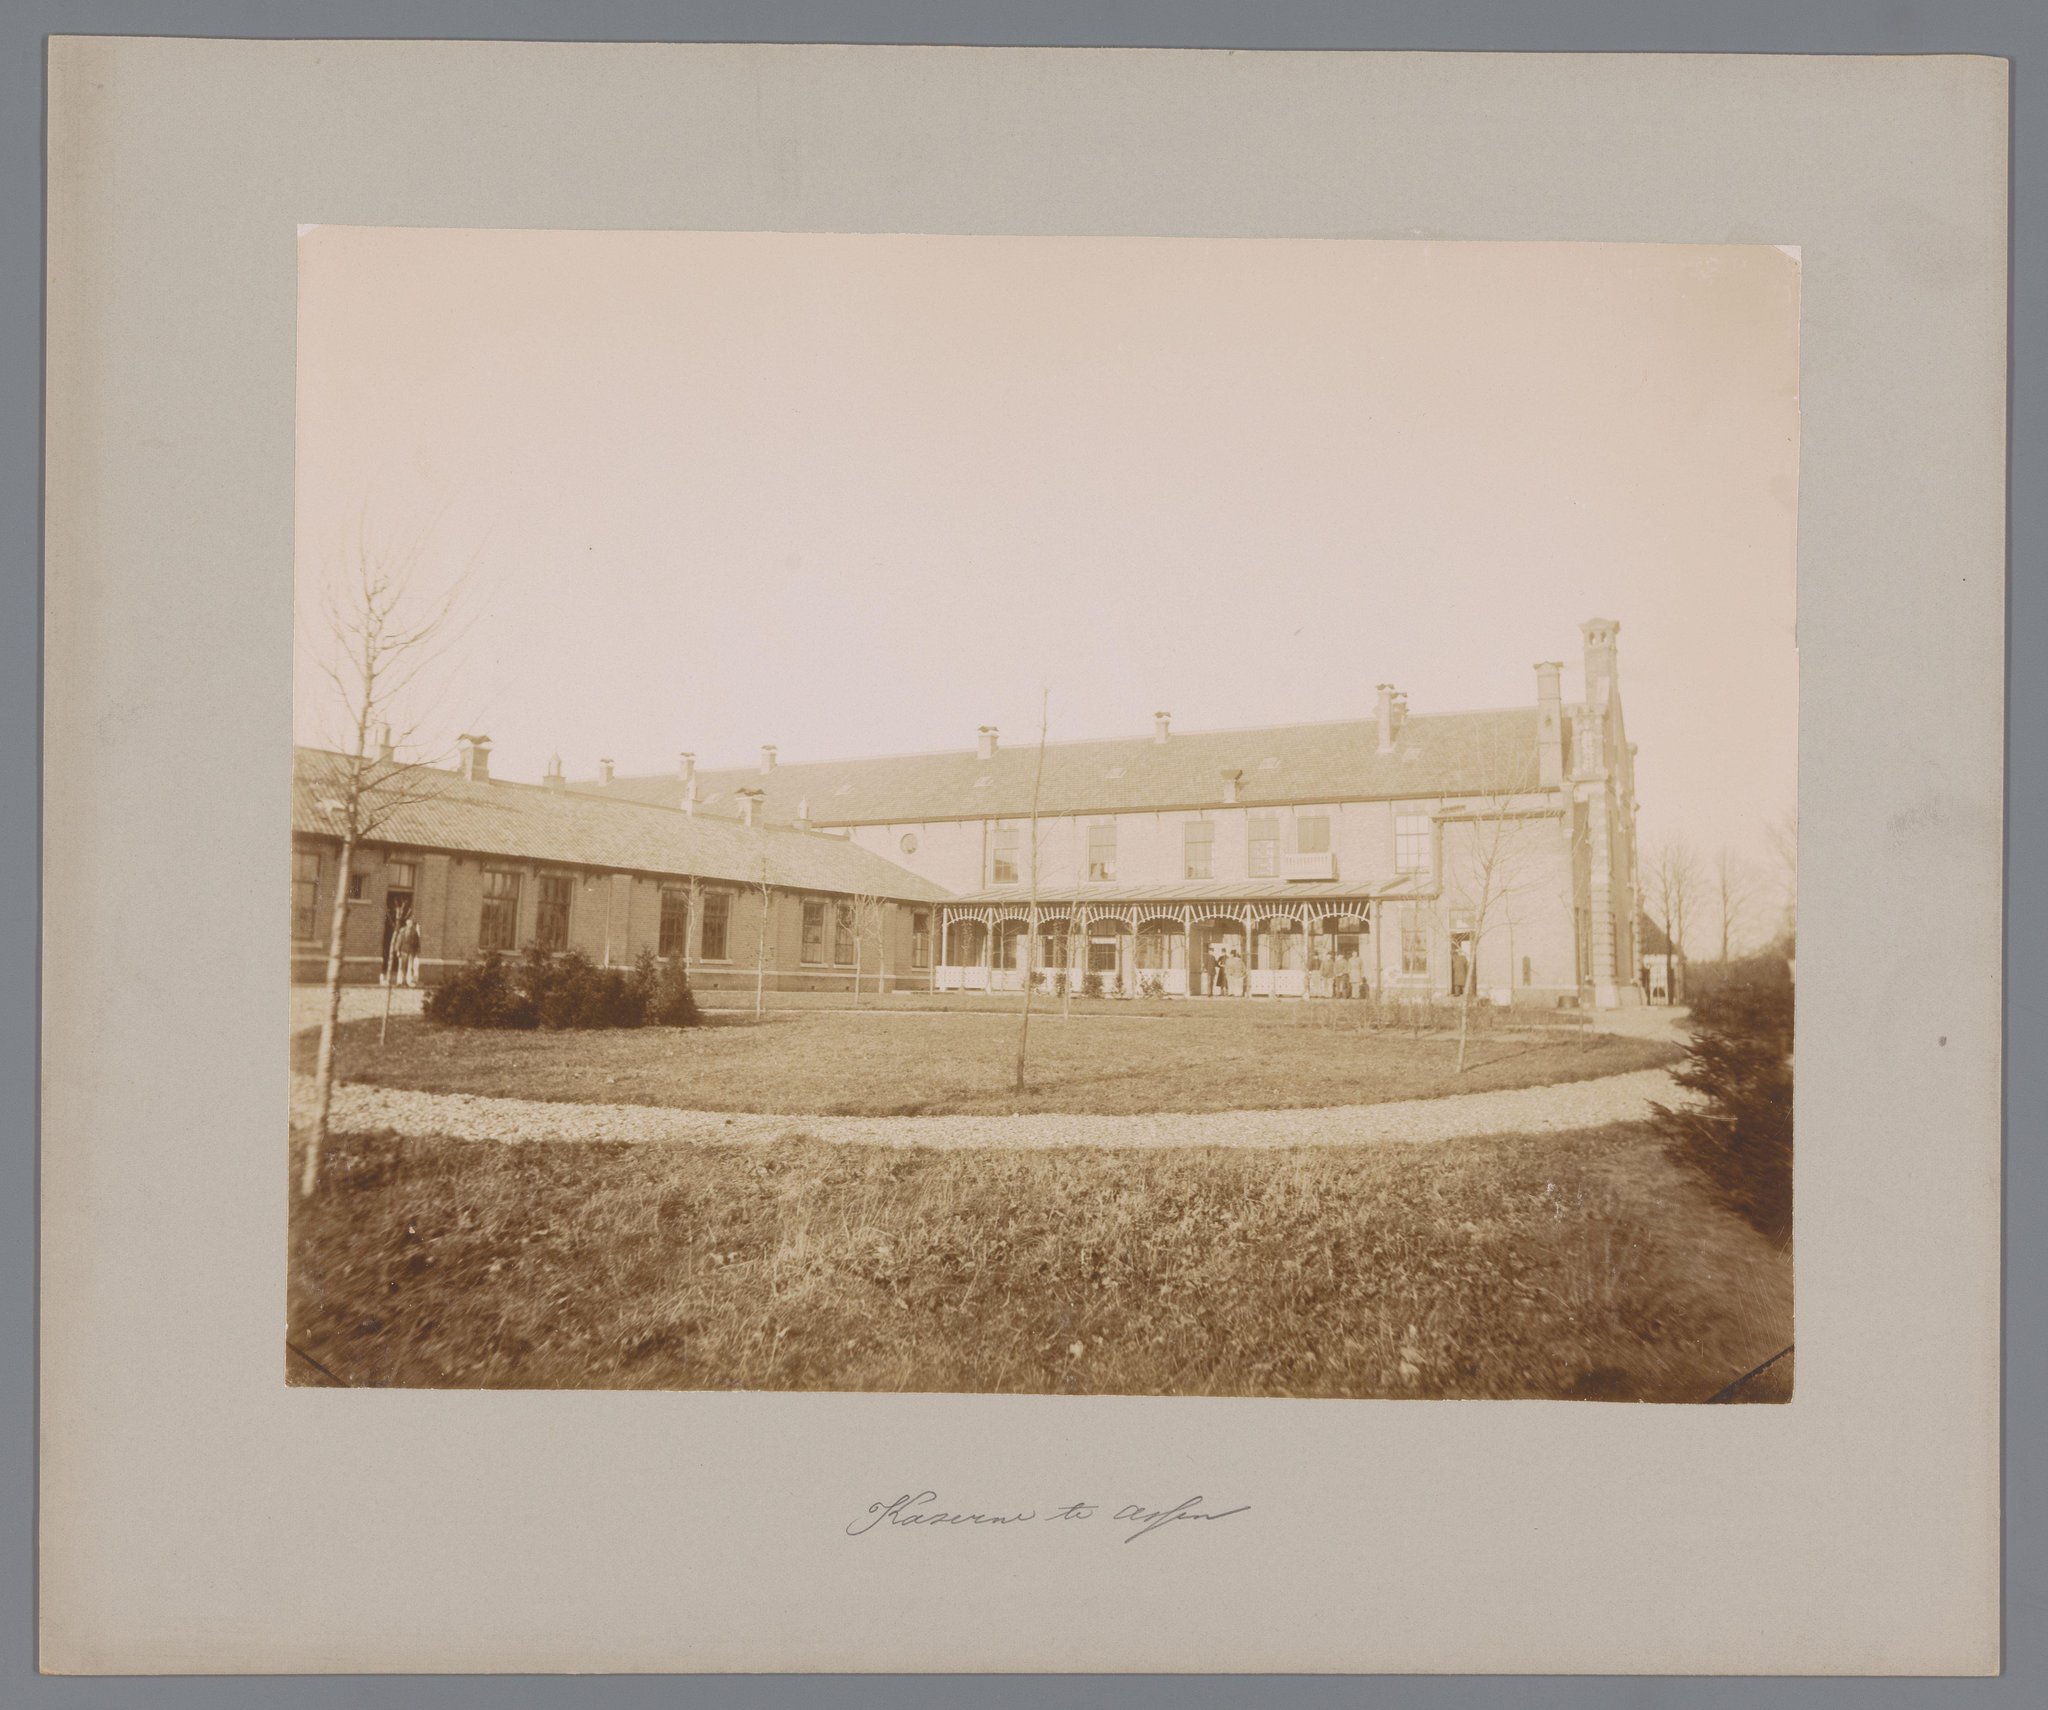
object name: photograph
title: Gezicht op de Johan Willem Frisokazerne te Assen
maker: Anonymous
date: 1892-1920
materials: cardboard, photographic support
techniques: collodion silver print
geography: assen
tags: military academy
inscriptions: annotation: ‘Kazerne te Assen’